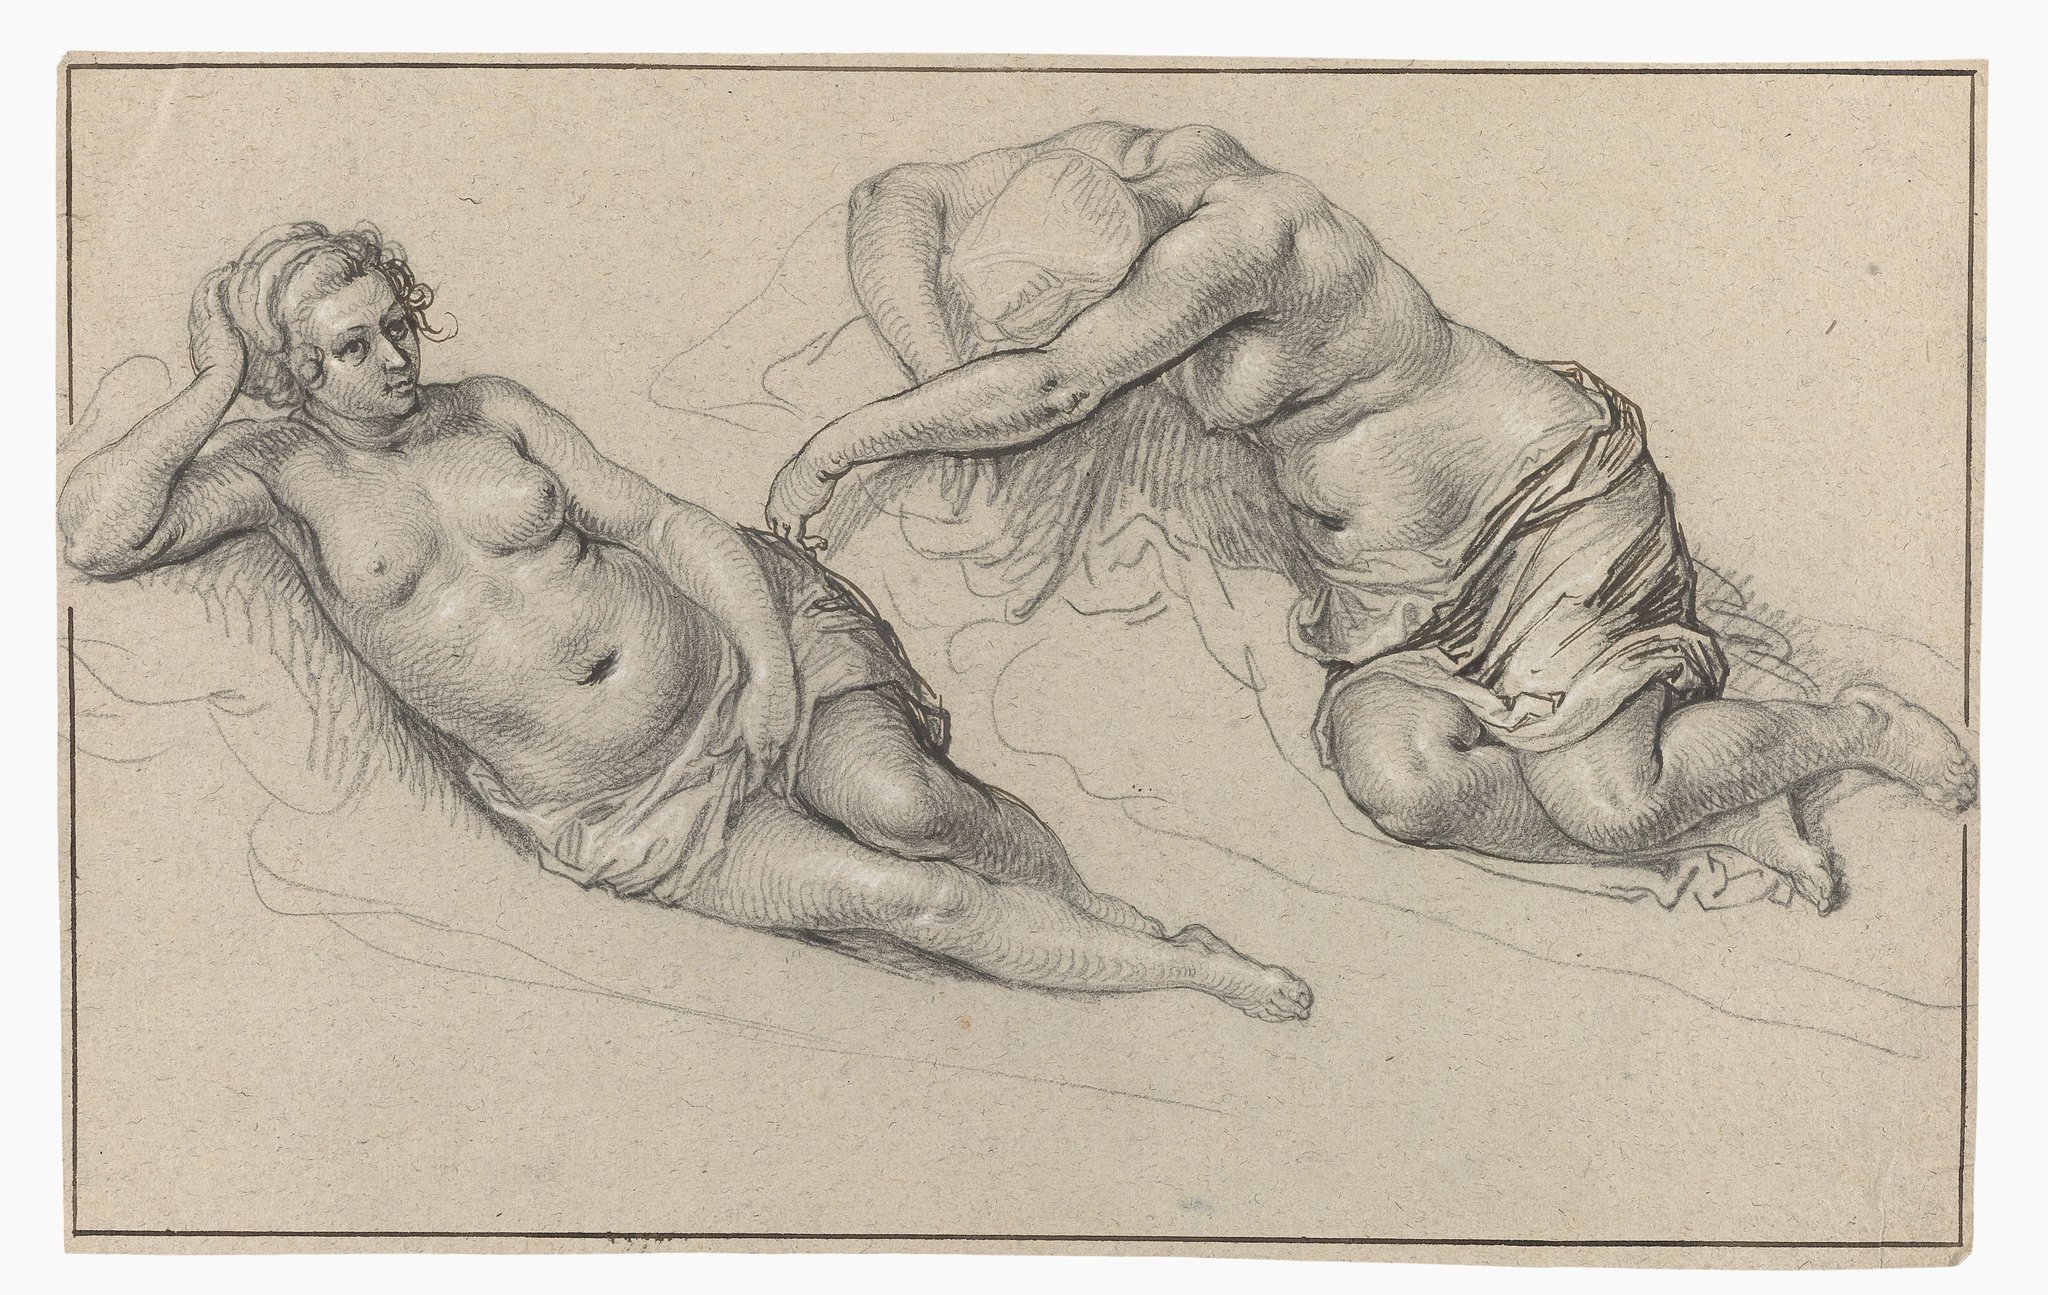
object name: drawing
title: Two Studies of a Nude Woman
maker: jacques de gheyn (ii)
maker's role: painter, print maker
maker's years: 1565-1629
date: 1603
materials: chalk, ink, paper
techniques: pen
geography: the hague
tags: woman (showing herself) undressed, quasi-nude, lying figure - aa - female human figure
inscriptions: date: ‘IV-1960’, annotation: ‘de geijn f’, number: ‘60, 24, 7’, : ‘ƒ 1:10:--’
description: This is one of the earliest preserved Dutch drawings of a posed nude female model. De Gheyn dazzles the viewer with his direct observation and spontaneous drawing style. Fine hatching suggests not only the shadows, but also reinforces the musculature and curvature of the body. De Gheyn enlivened the drawing in places with accents in pen and ink.